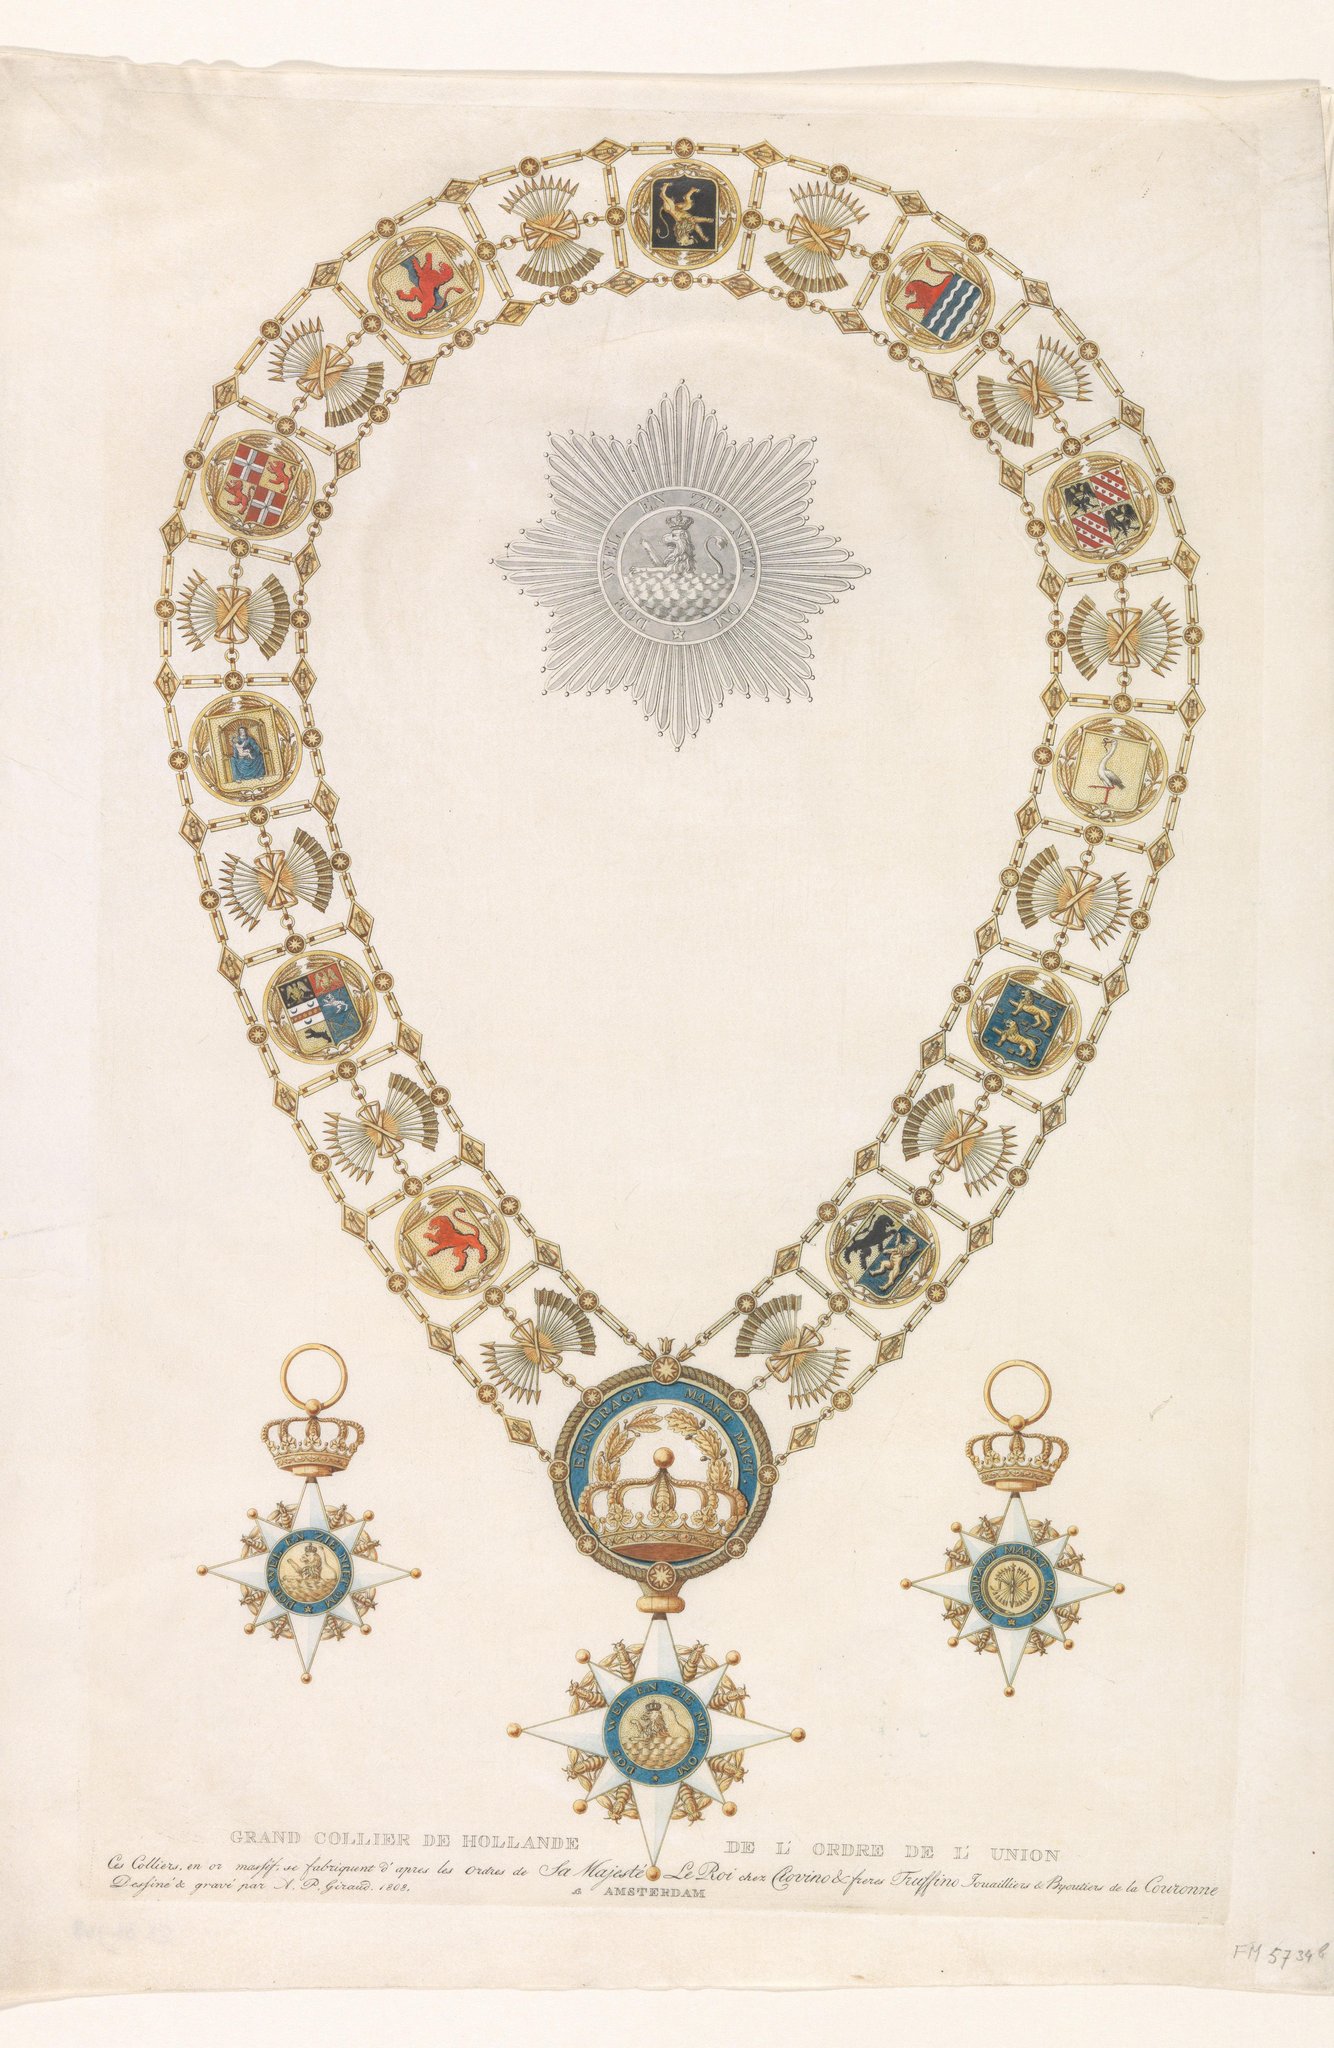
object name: print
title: Grand collier de Hollande de l'ordre de l'union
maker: alphonse pierre giraud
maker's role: print maker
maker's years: 1786-1863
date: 1808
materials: parchment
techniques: etching, hand coloring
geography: amsterdam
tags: louis napoleon (king of holland), knighthood order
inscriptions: date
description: Het Grote Keten met het kruis van de Koninklijke Orde van Holland, later genoemd Orde van de Unie. Onderscheiding ingesteld door koning Lodewijk Napoleon, voor het eerst in 1806. Deze variant van het versiersel met een zwemmende of uitkomende leeuw dateert van 14 februari 1807. Op ware grootte. In deze staat zijn toegevoegd: centraal de geborduurde ster, onderaan apart de voorzijde en achterzijde van het grootkruis. In het onderschrift is vermeld de naam van de makers van het ordeteken, de Amsterdamse juweliersfirma Ciovino & Gebr. Truffino.